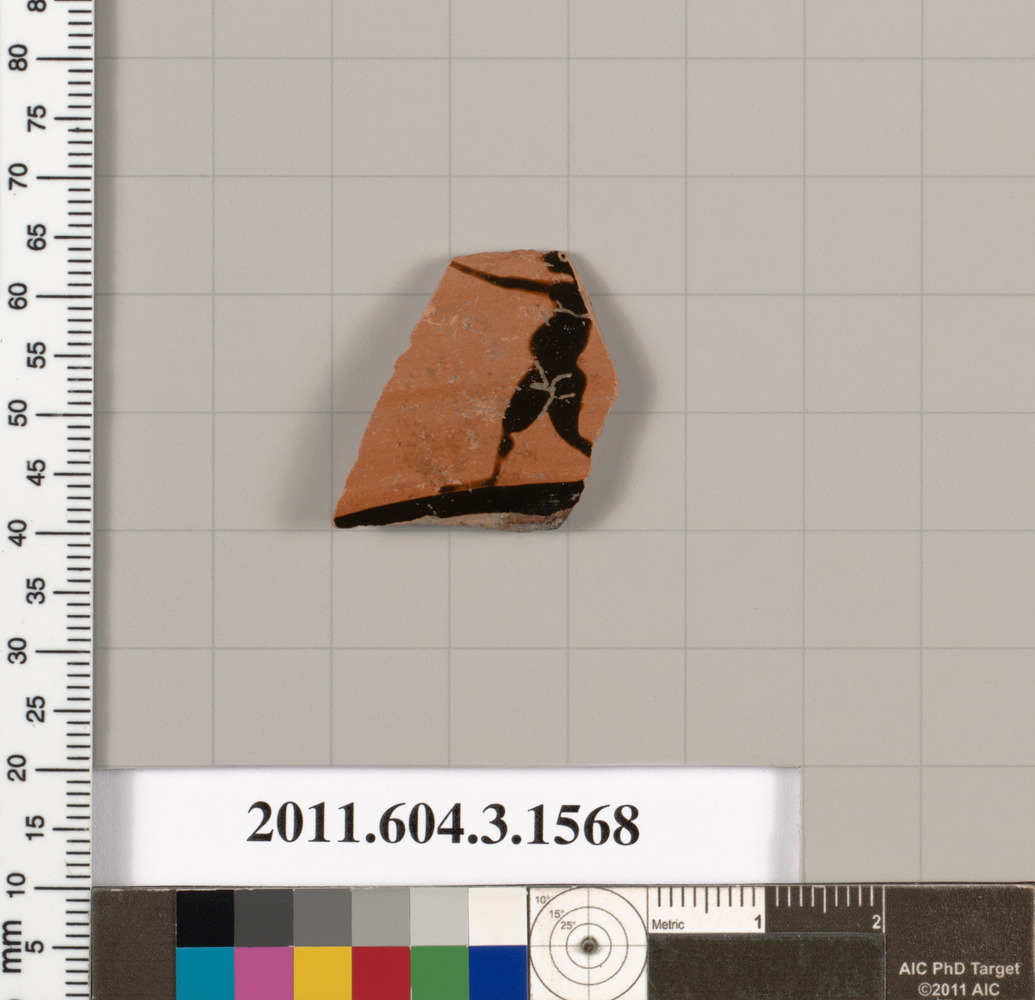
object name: kylix fragment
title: Terracotta fragment of a kylix: Band cup (drinking cup)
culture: greek, attic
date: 550-526 BCE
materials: terracotta